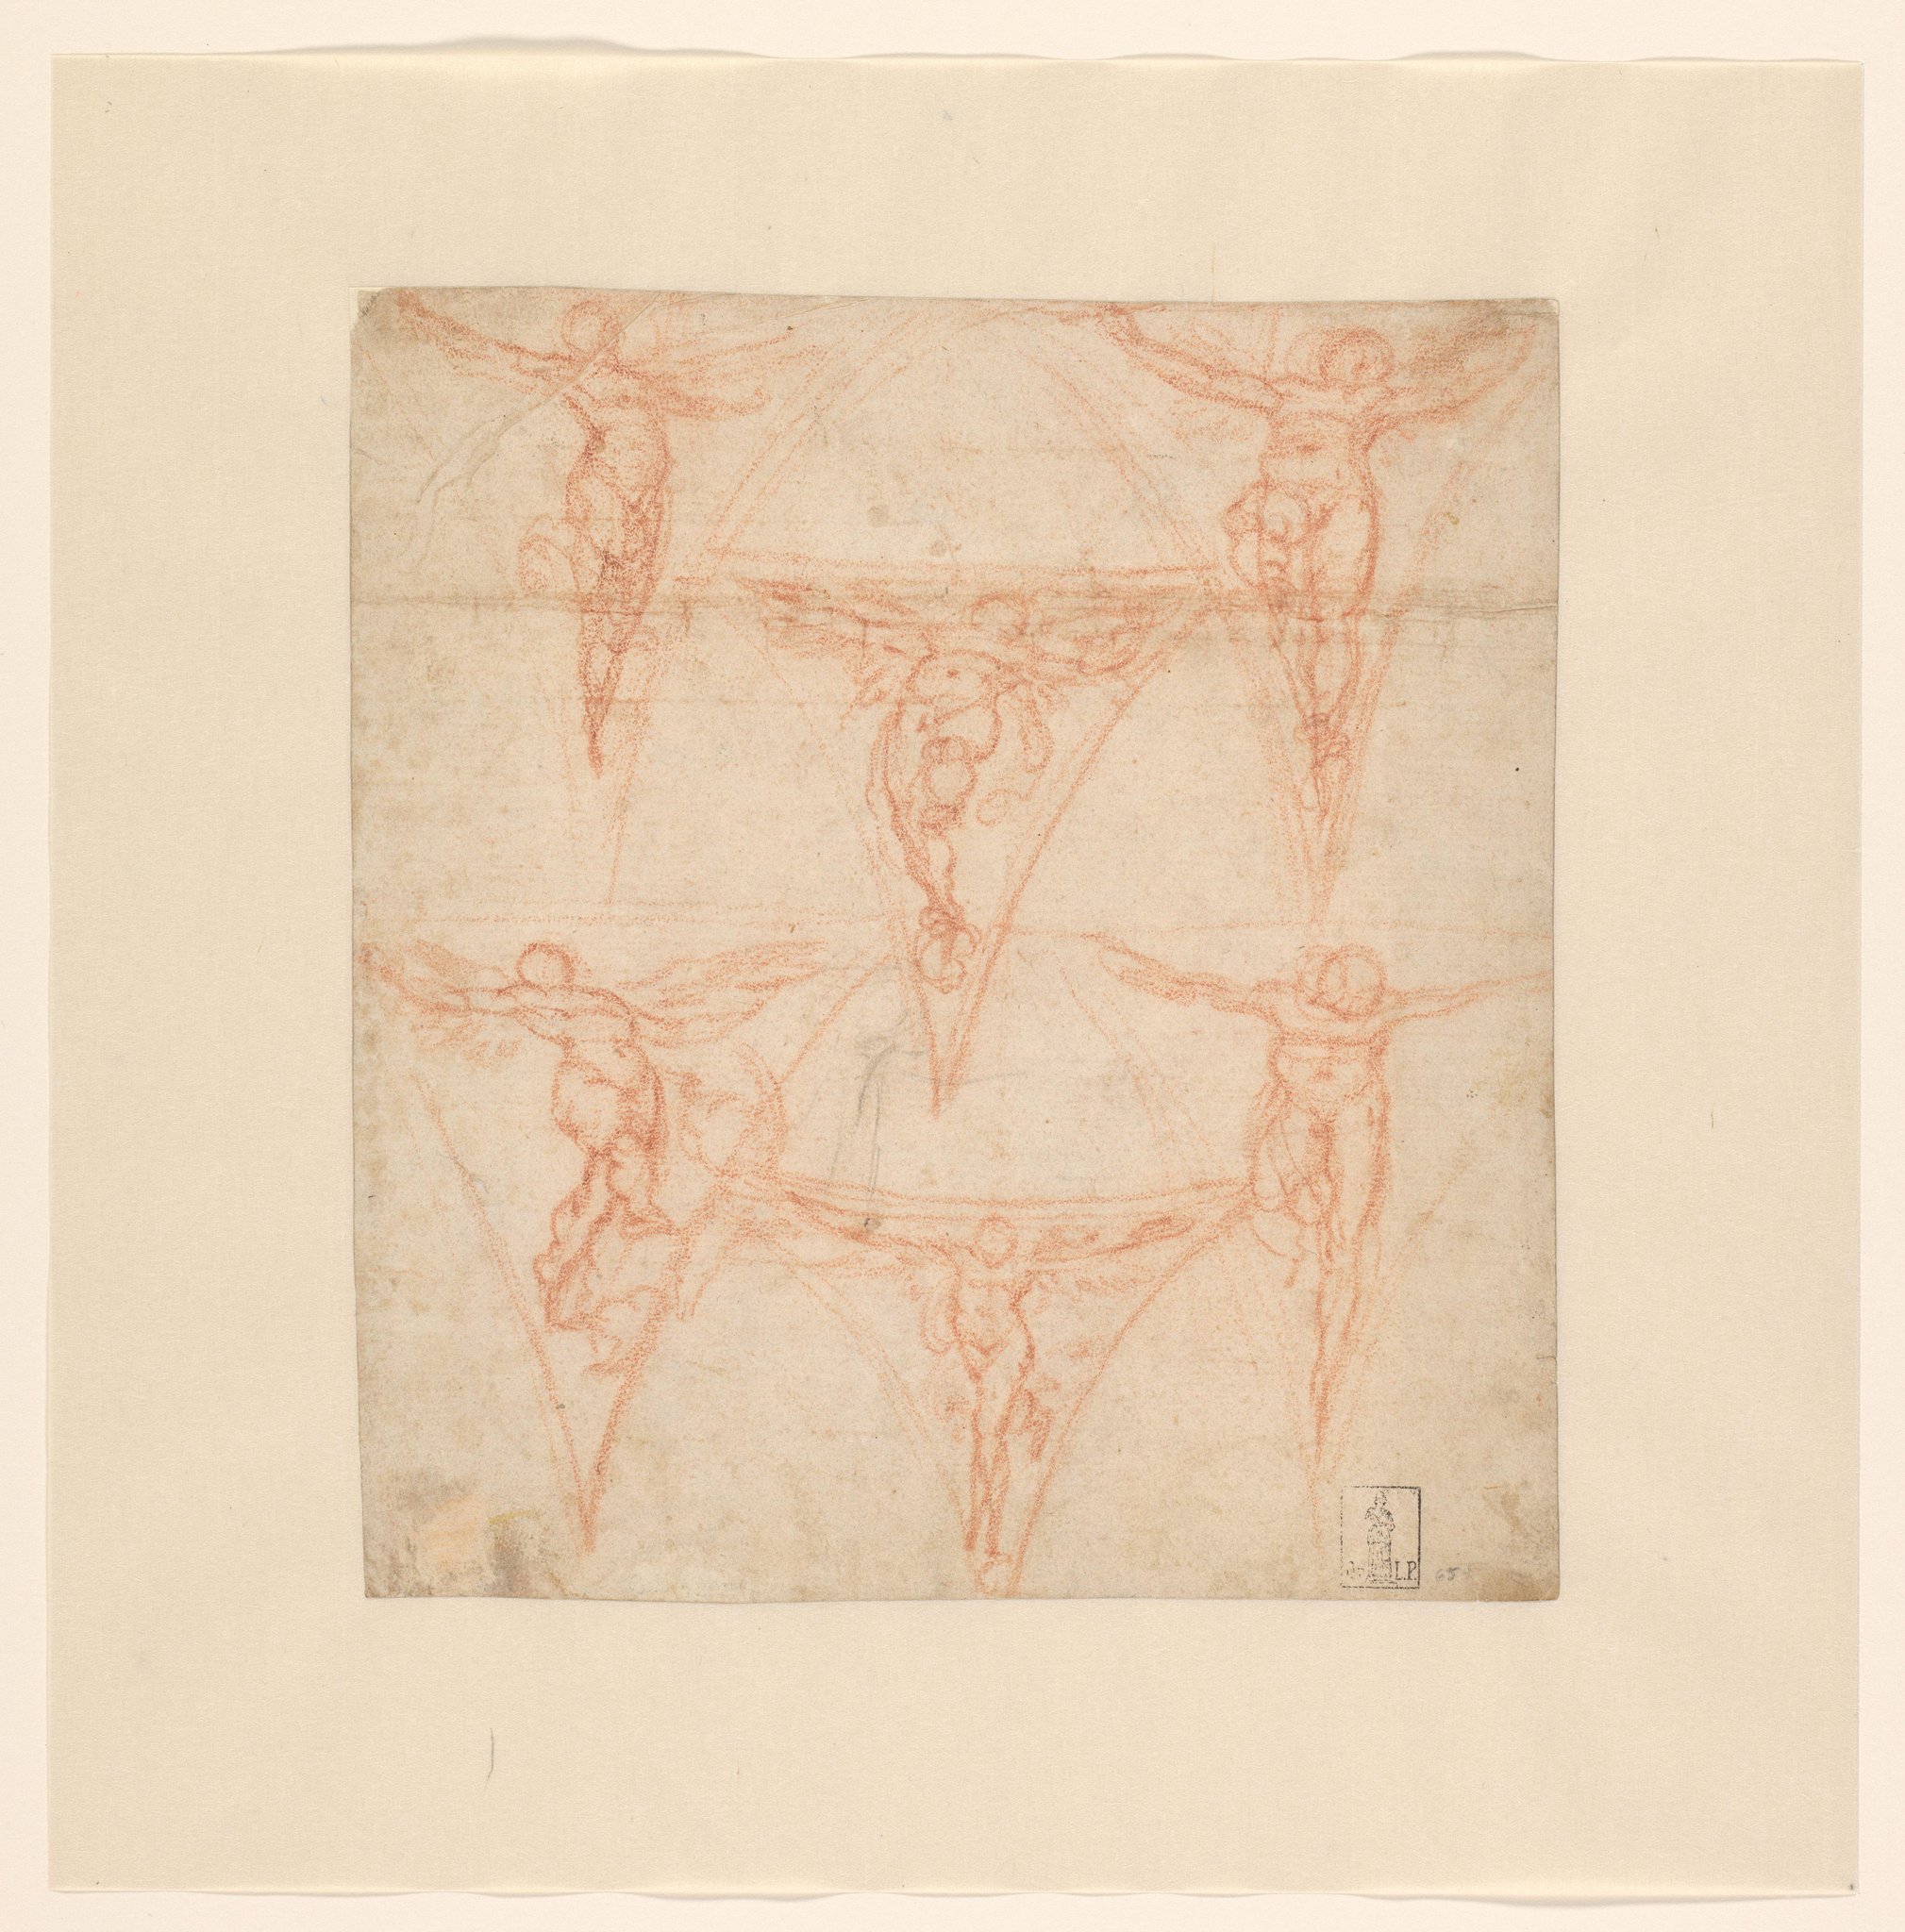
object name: drawing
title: Zes ontwerpen voor zwikvullingen met zwevende engelen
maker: cherubino alberti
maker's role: draughtsman, print maker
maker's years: 1553-1615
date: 1563-1615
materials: chalk, paper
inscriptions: collector's mark: Lugt 788b